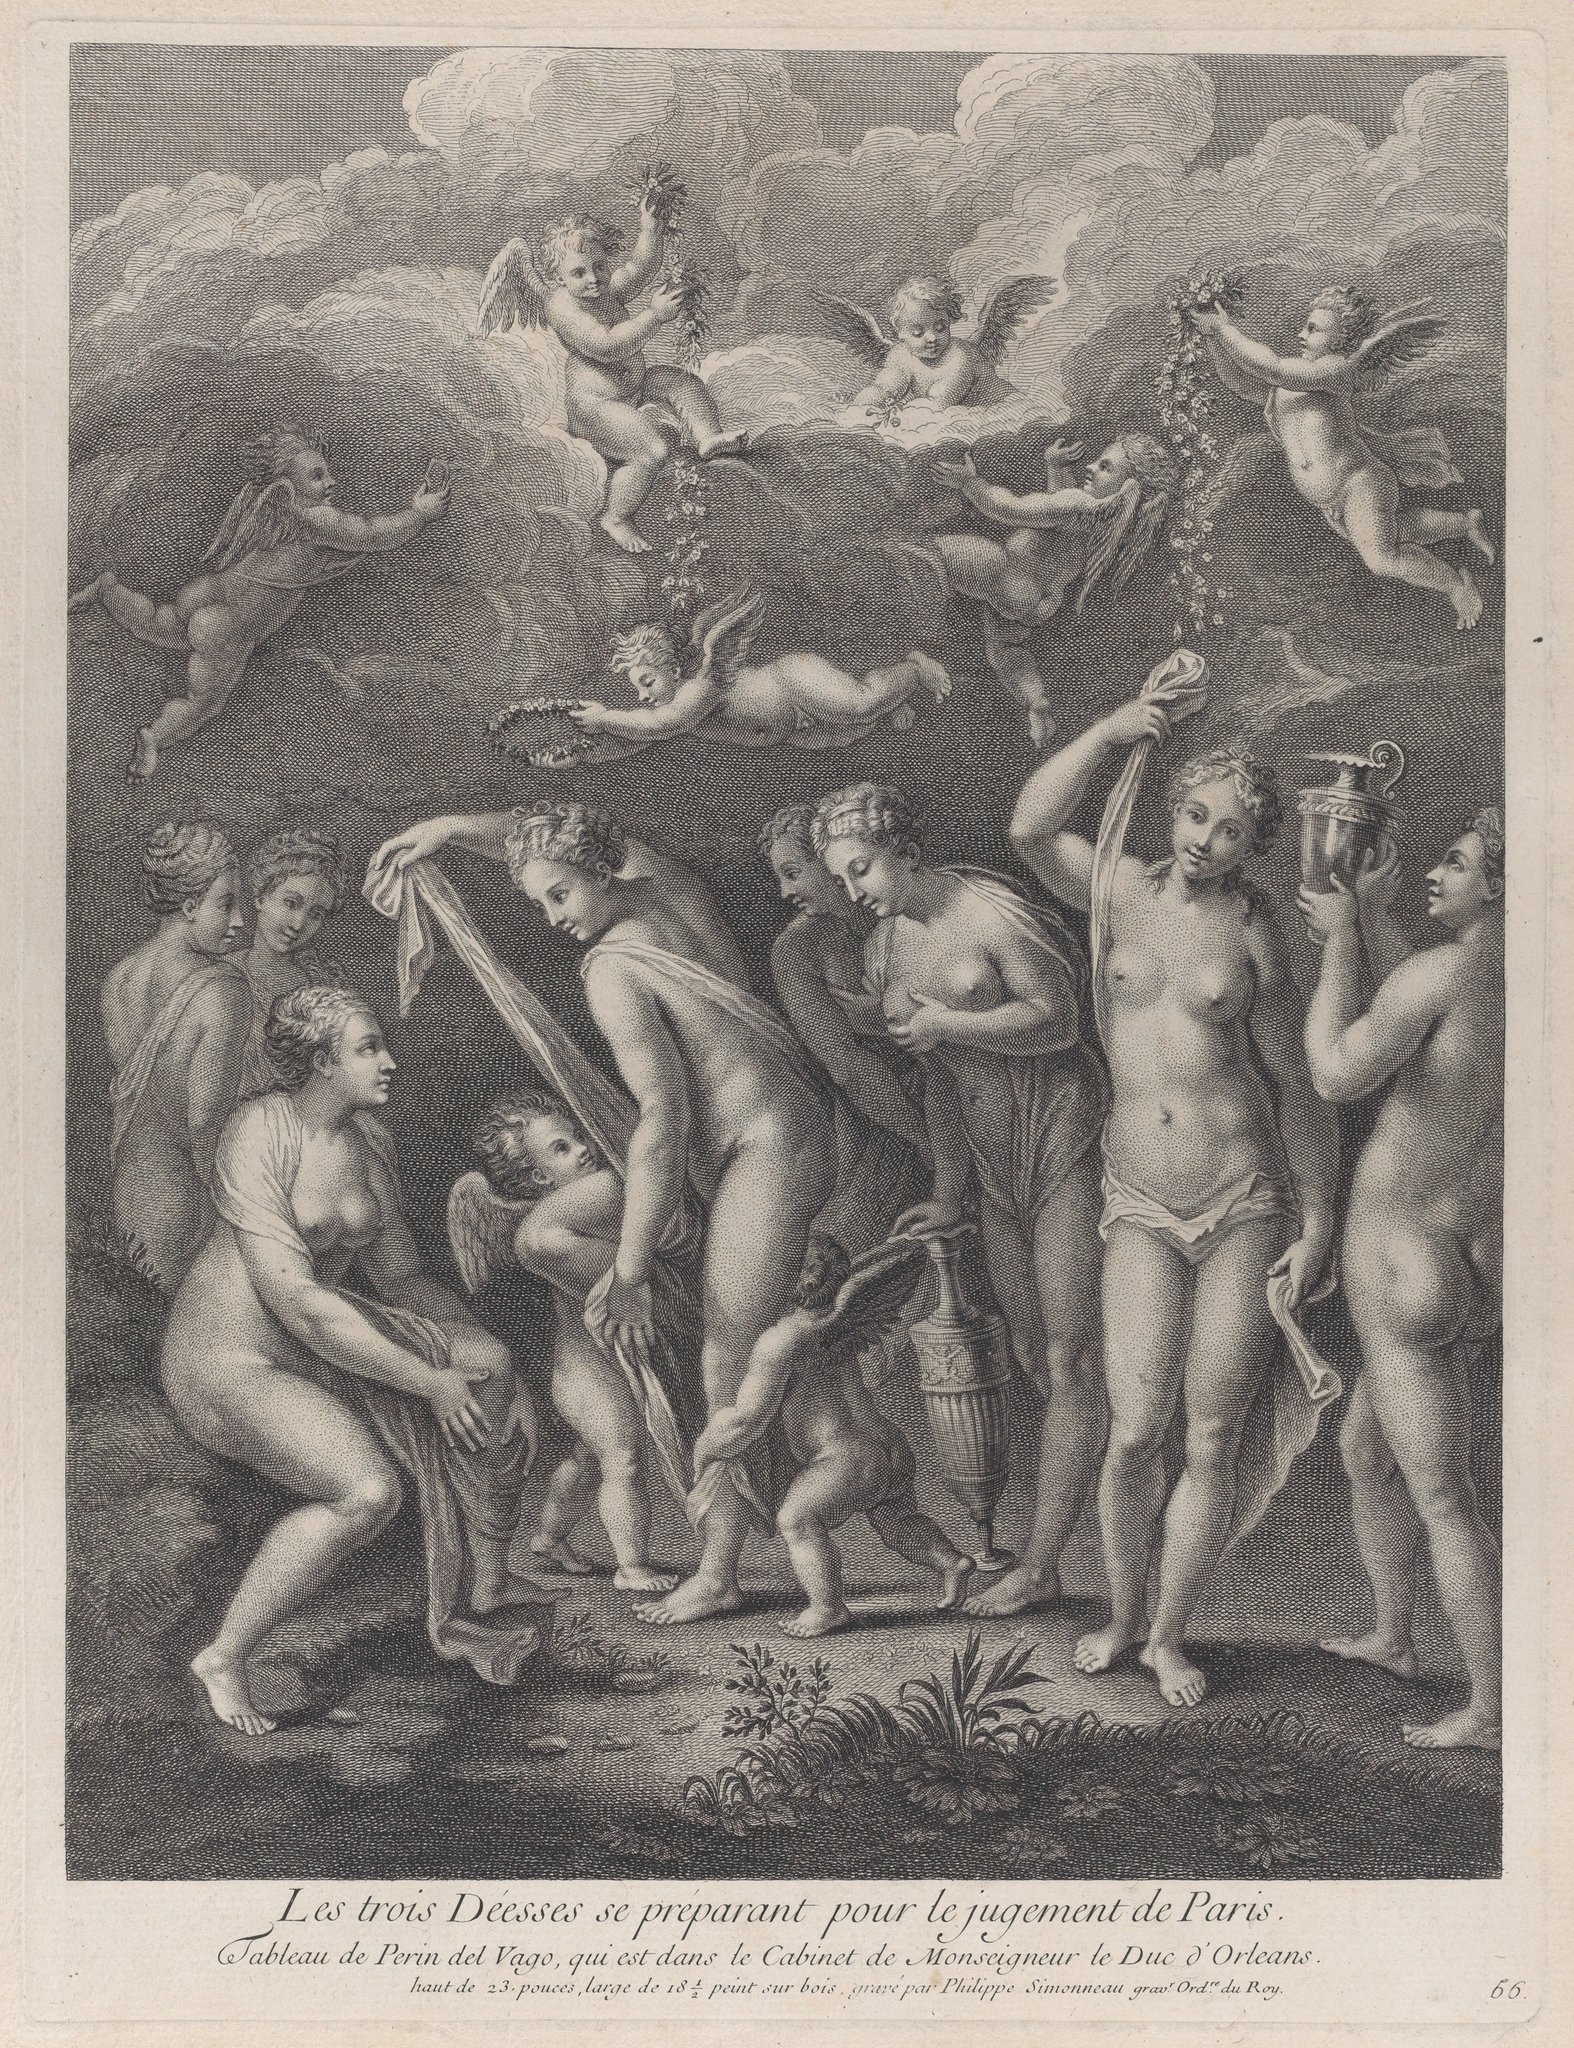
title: Hera, Aphrodite, and Athena preparing themselves for the contest of beauty before Paris; from 'Recueil d'estampes d'après les plus beaux tableaux et d'après les plus beaux desseins qui sont en France, Cabinet Crozat' after Perino del Vaga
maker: philippe simonneau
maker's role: artist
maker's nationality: french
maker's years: 1685-1785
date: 1729-1740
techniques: engraving, etching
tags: female nudes,juno,minerva,venus